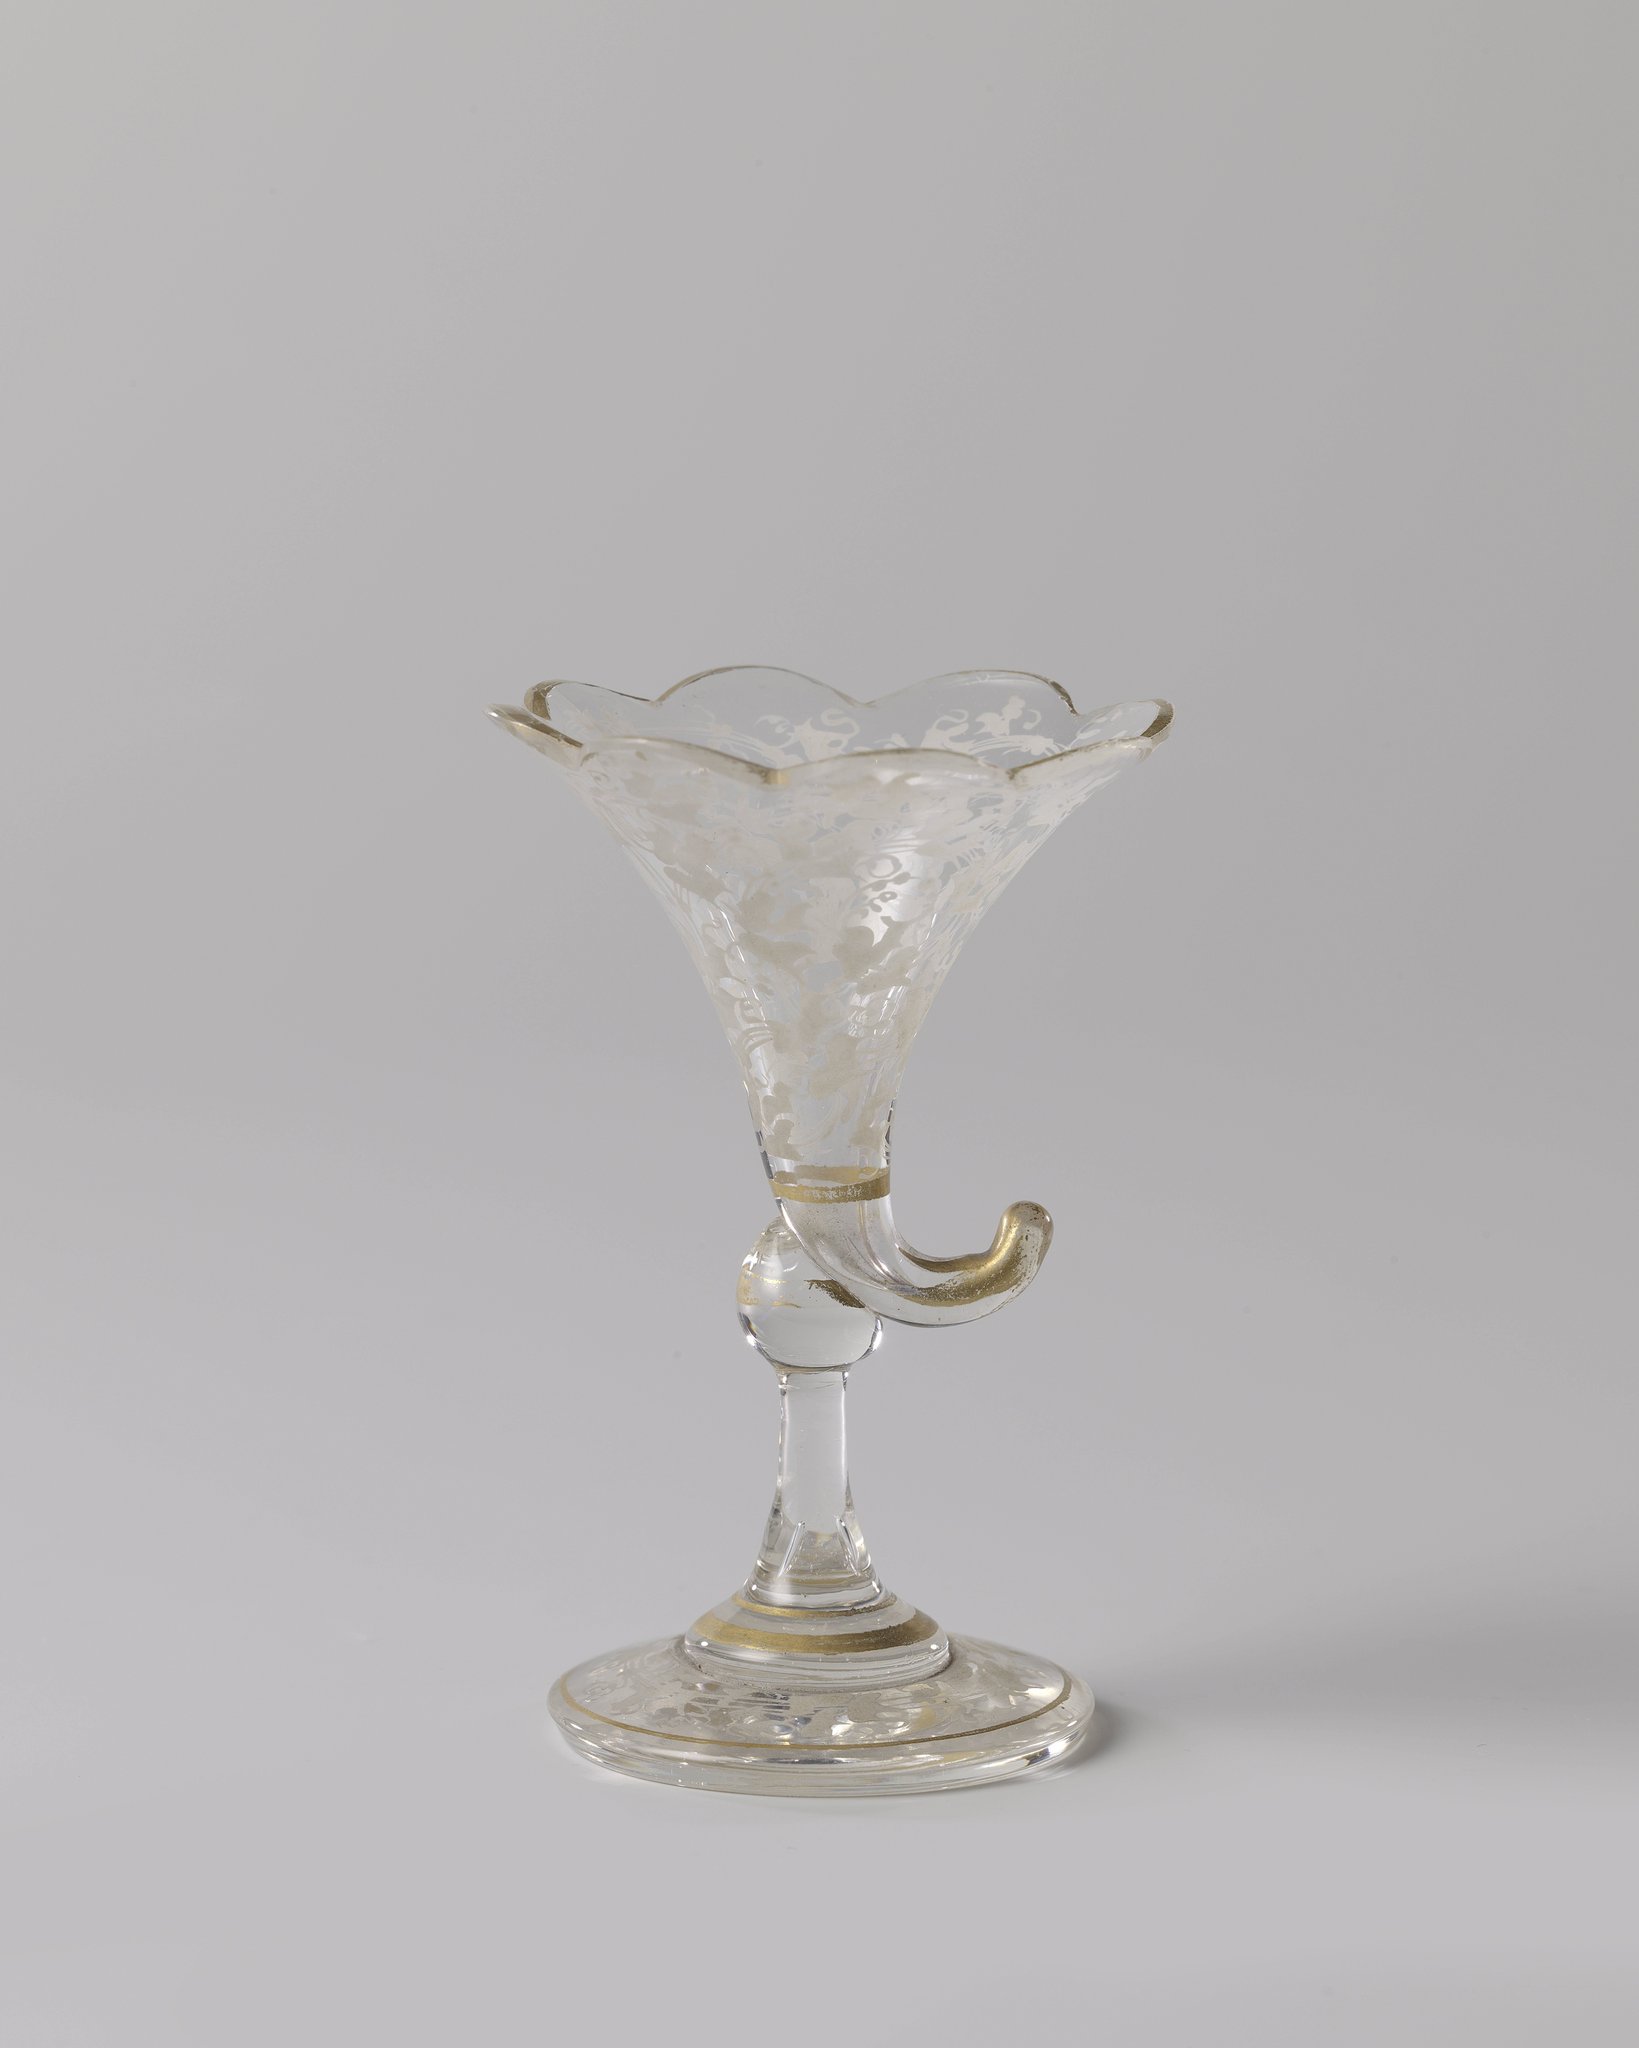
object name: goblet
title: Kelkglas met bladvoluten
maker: Anonymous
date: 1850-1875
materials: glass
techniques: gilding, glassblowing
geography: france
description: Kleine kelkglas met platte voet. Naar boven smaller wordende stam met knoop. Hoornvormige kelk met golvende rand. De kelk en de voet zijn beschilderd in email met witte bladvoluten. Langs de randen vergulde biezen.